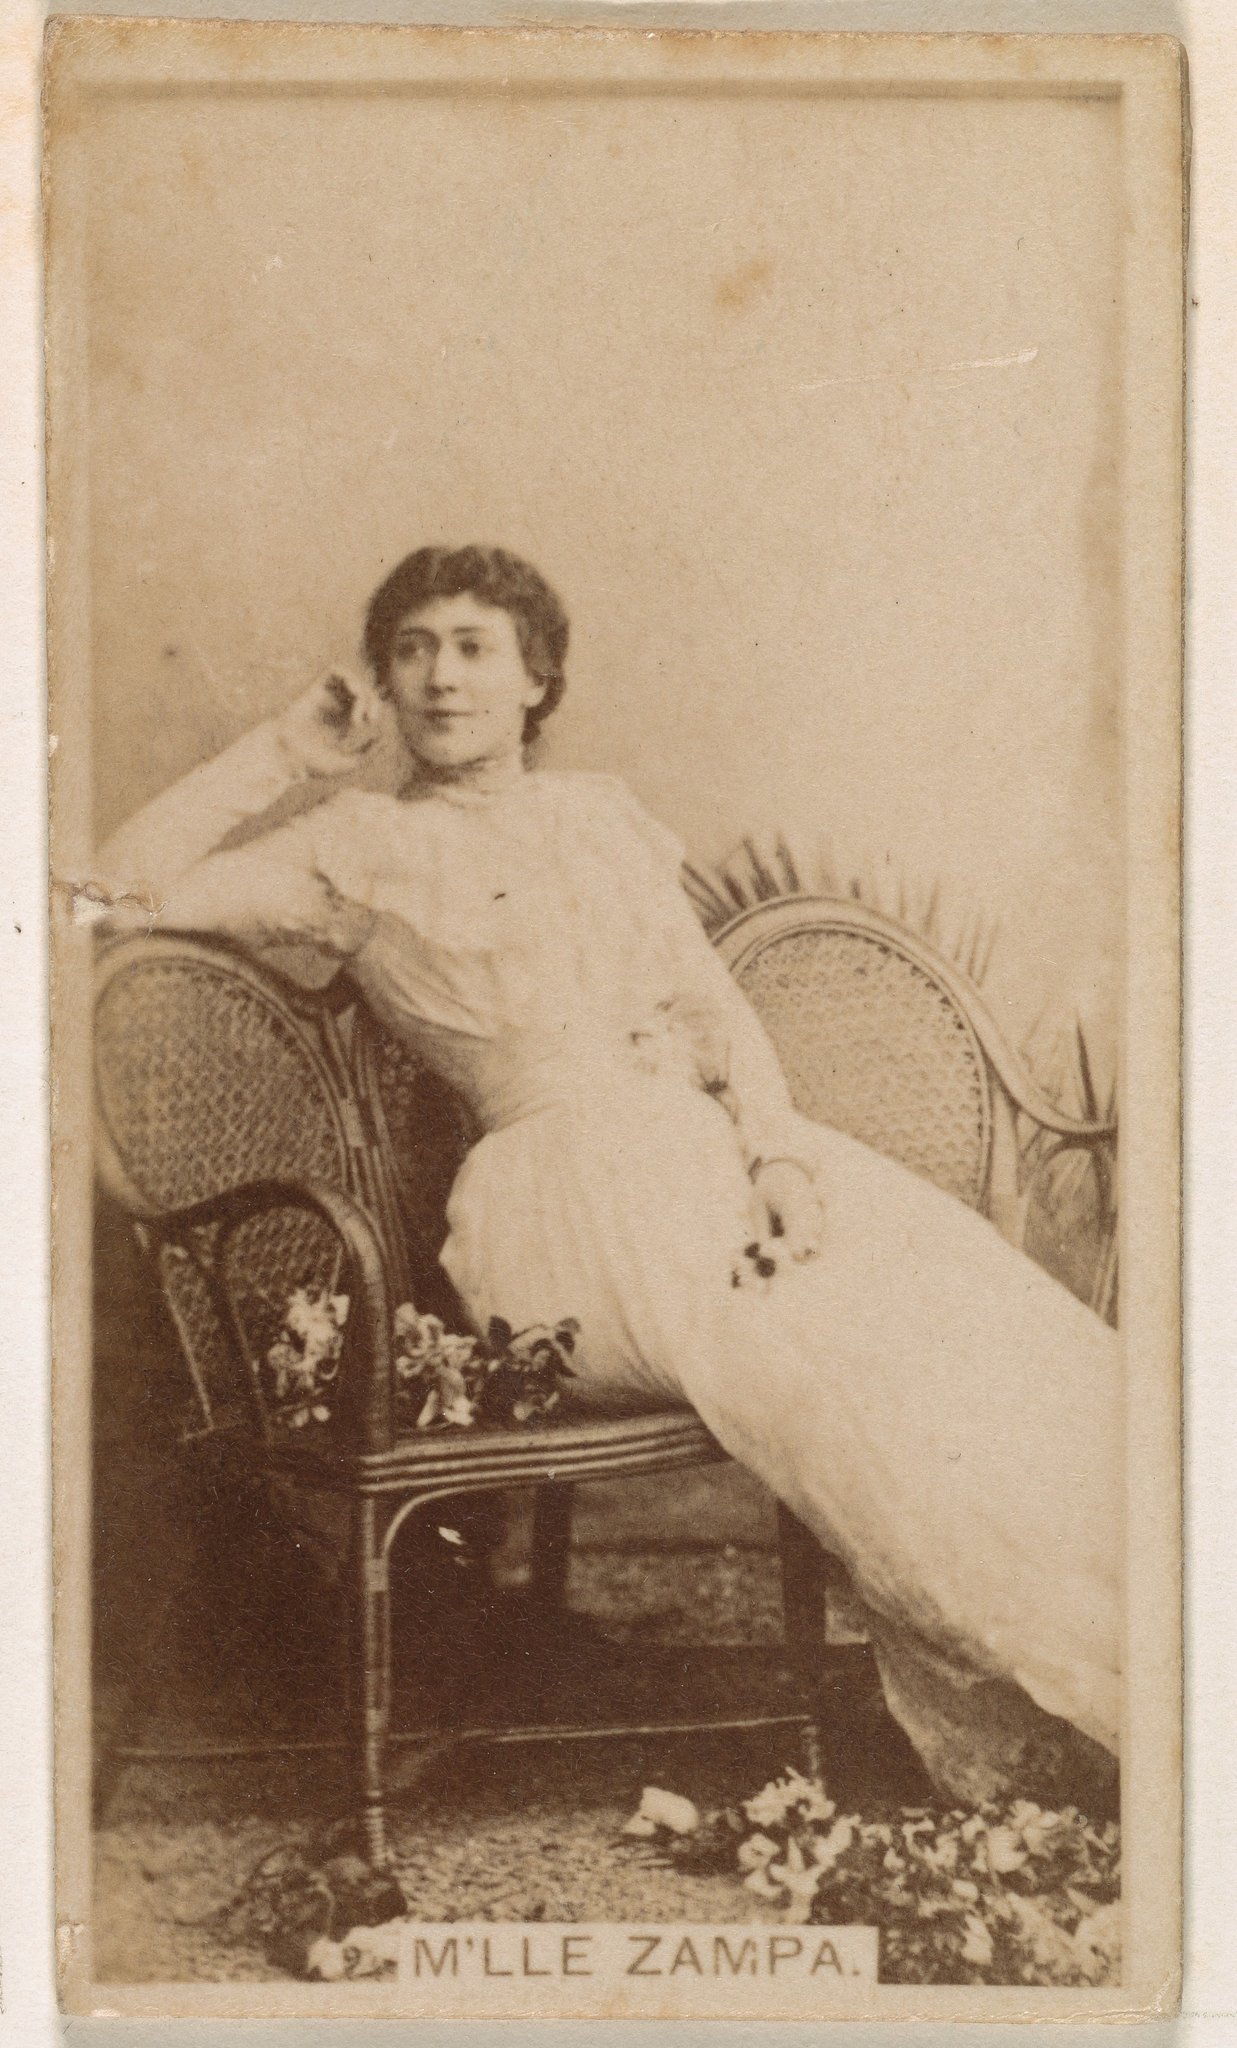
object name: photograph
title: M'lle Zampa, from the Actresses series (N245) issued by Kinney Brothers to promote Sweet Caporal Cigarettes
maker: kinney brothers tobacco company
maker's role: publisher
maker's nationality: american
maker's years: 1869-2011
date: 1890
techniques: albumen silver print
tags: portraits,women,actresses